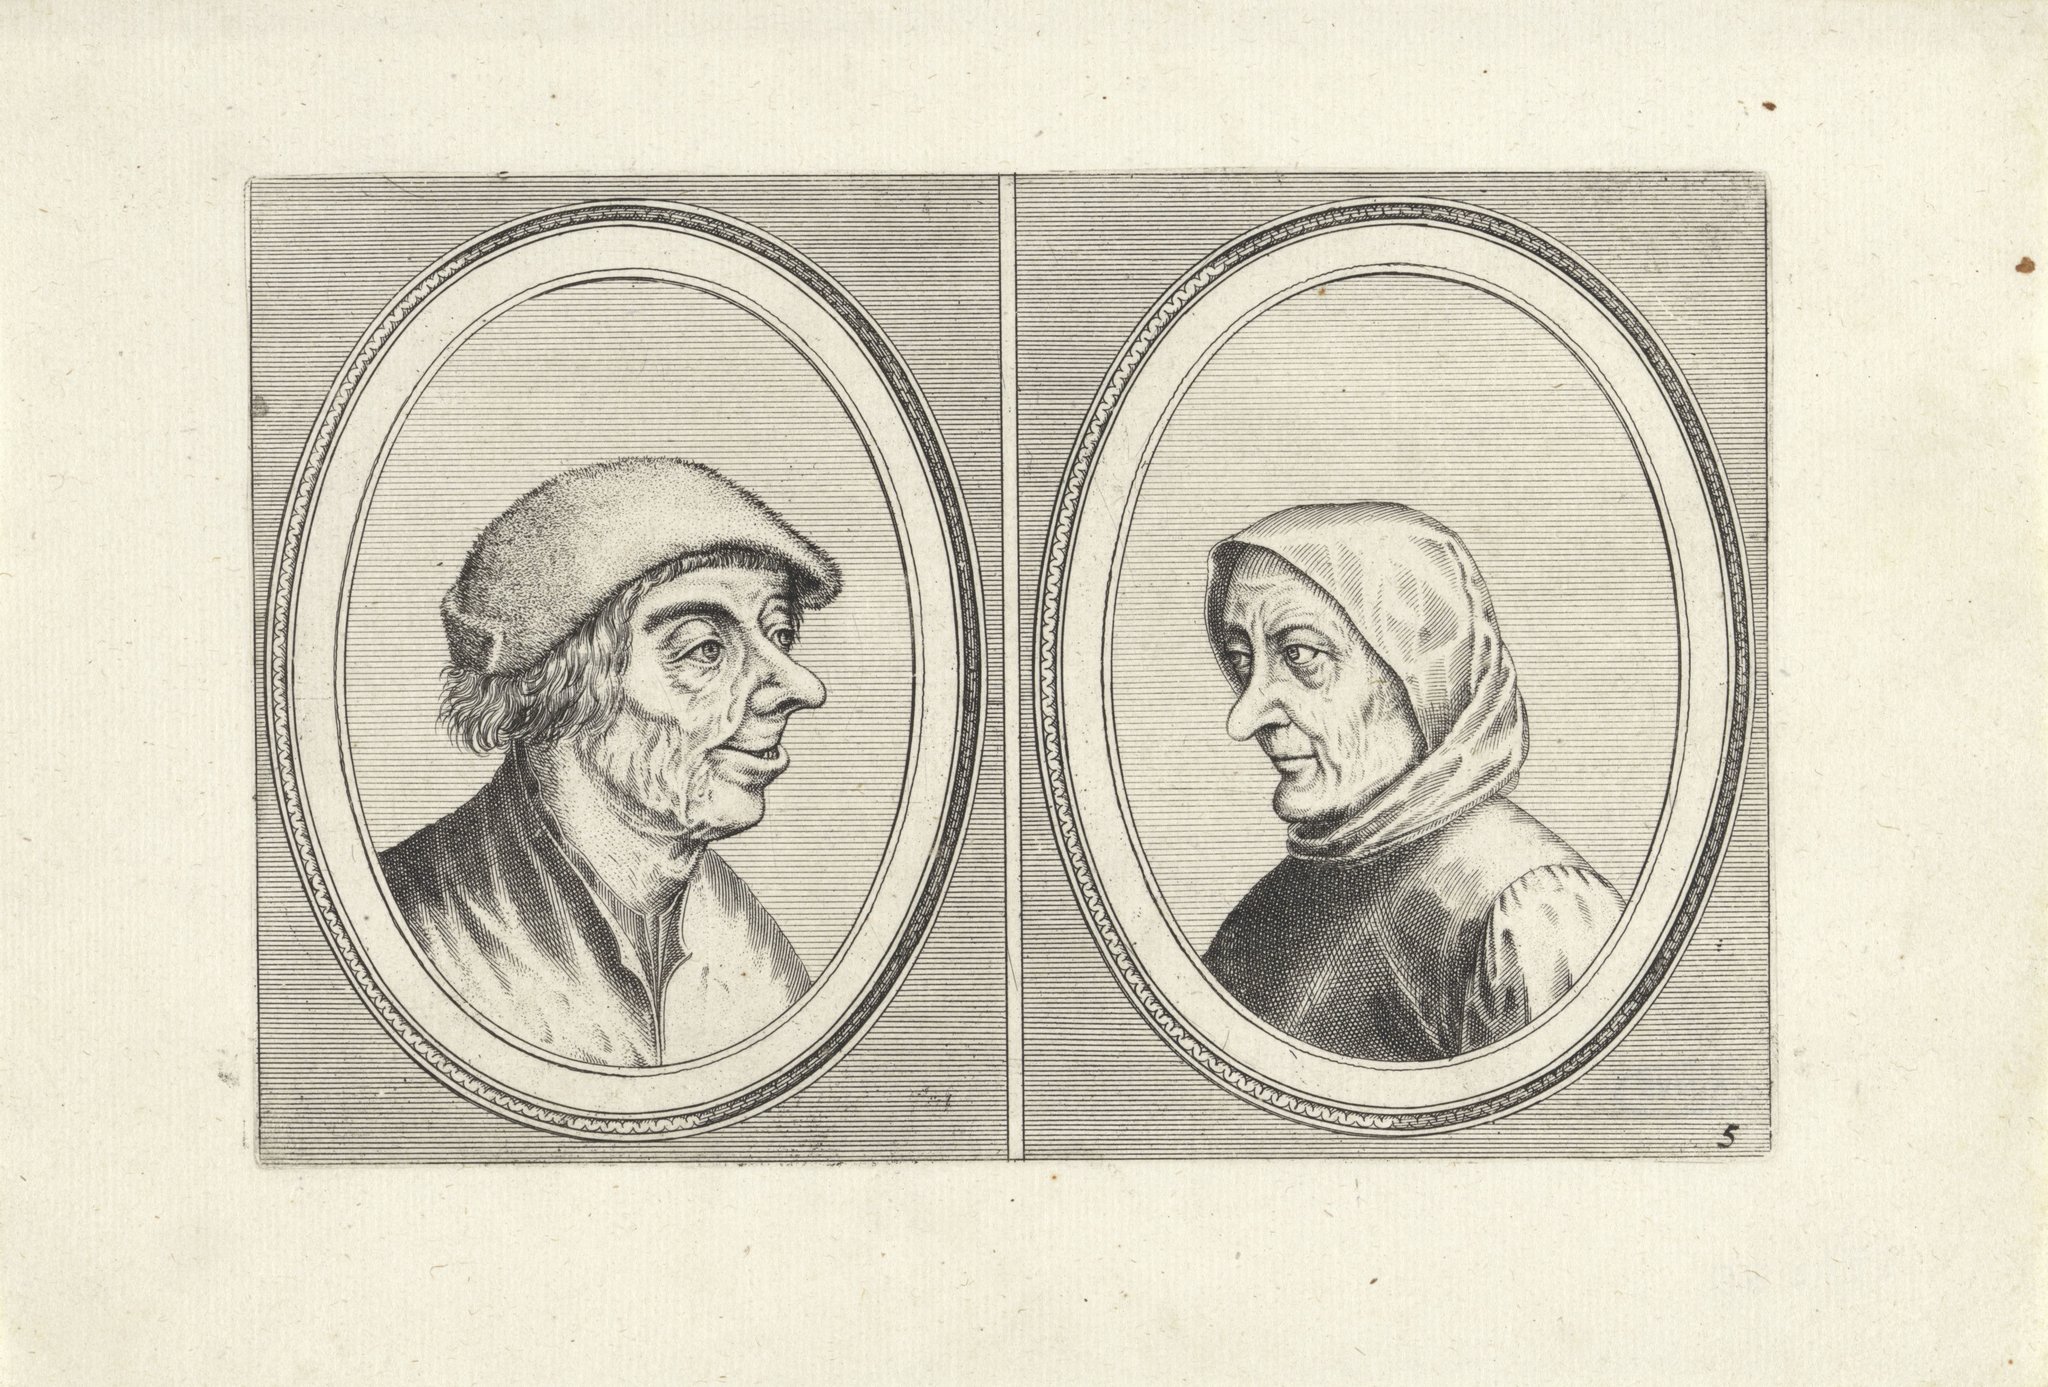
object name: print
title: Boerenkoppen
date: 1612-1652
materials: paper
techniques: engraving, etching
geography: amsterdam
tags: head-gear, farmers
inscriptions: collector's mark: Lugt 2228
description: Prent uit een serie van 36 prenten met koppen van boeren en boerinnen.